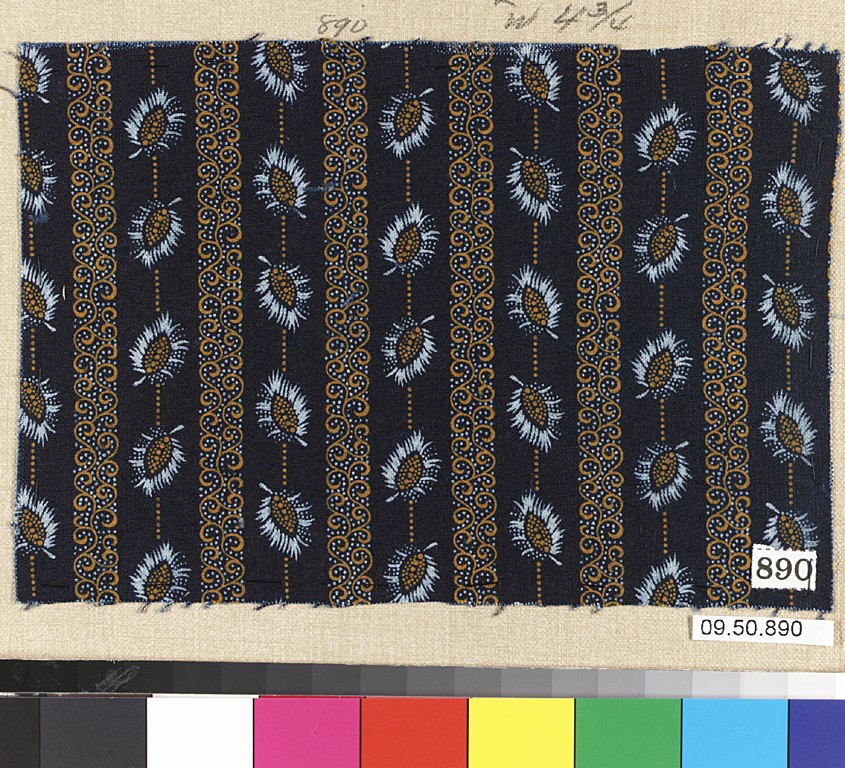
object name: piece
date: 1801-1900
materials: cotton